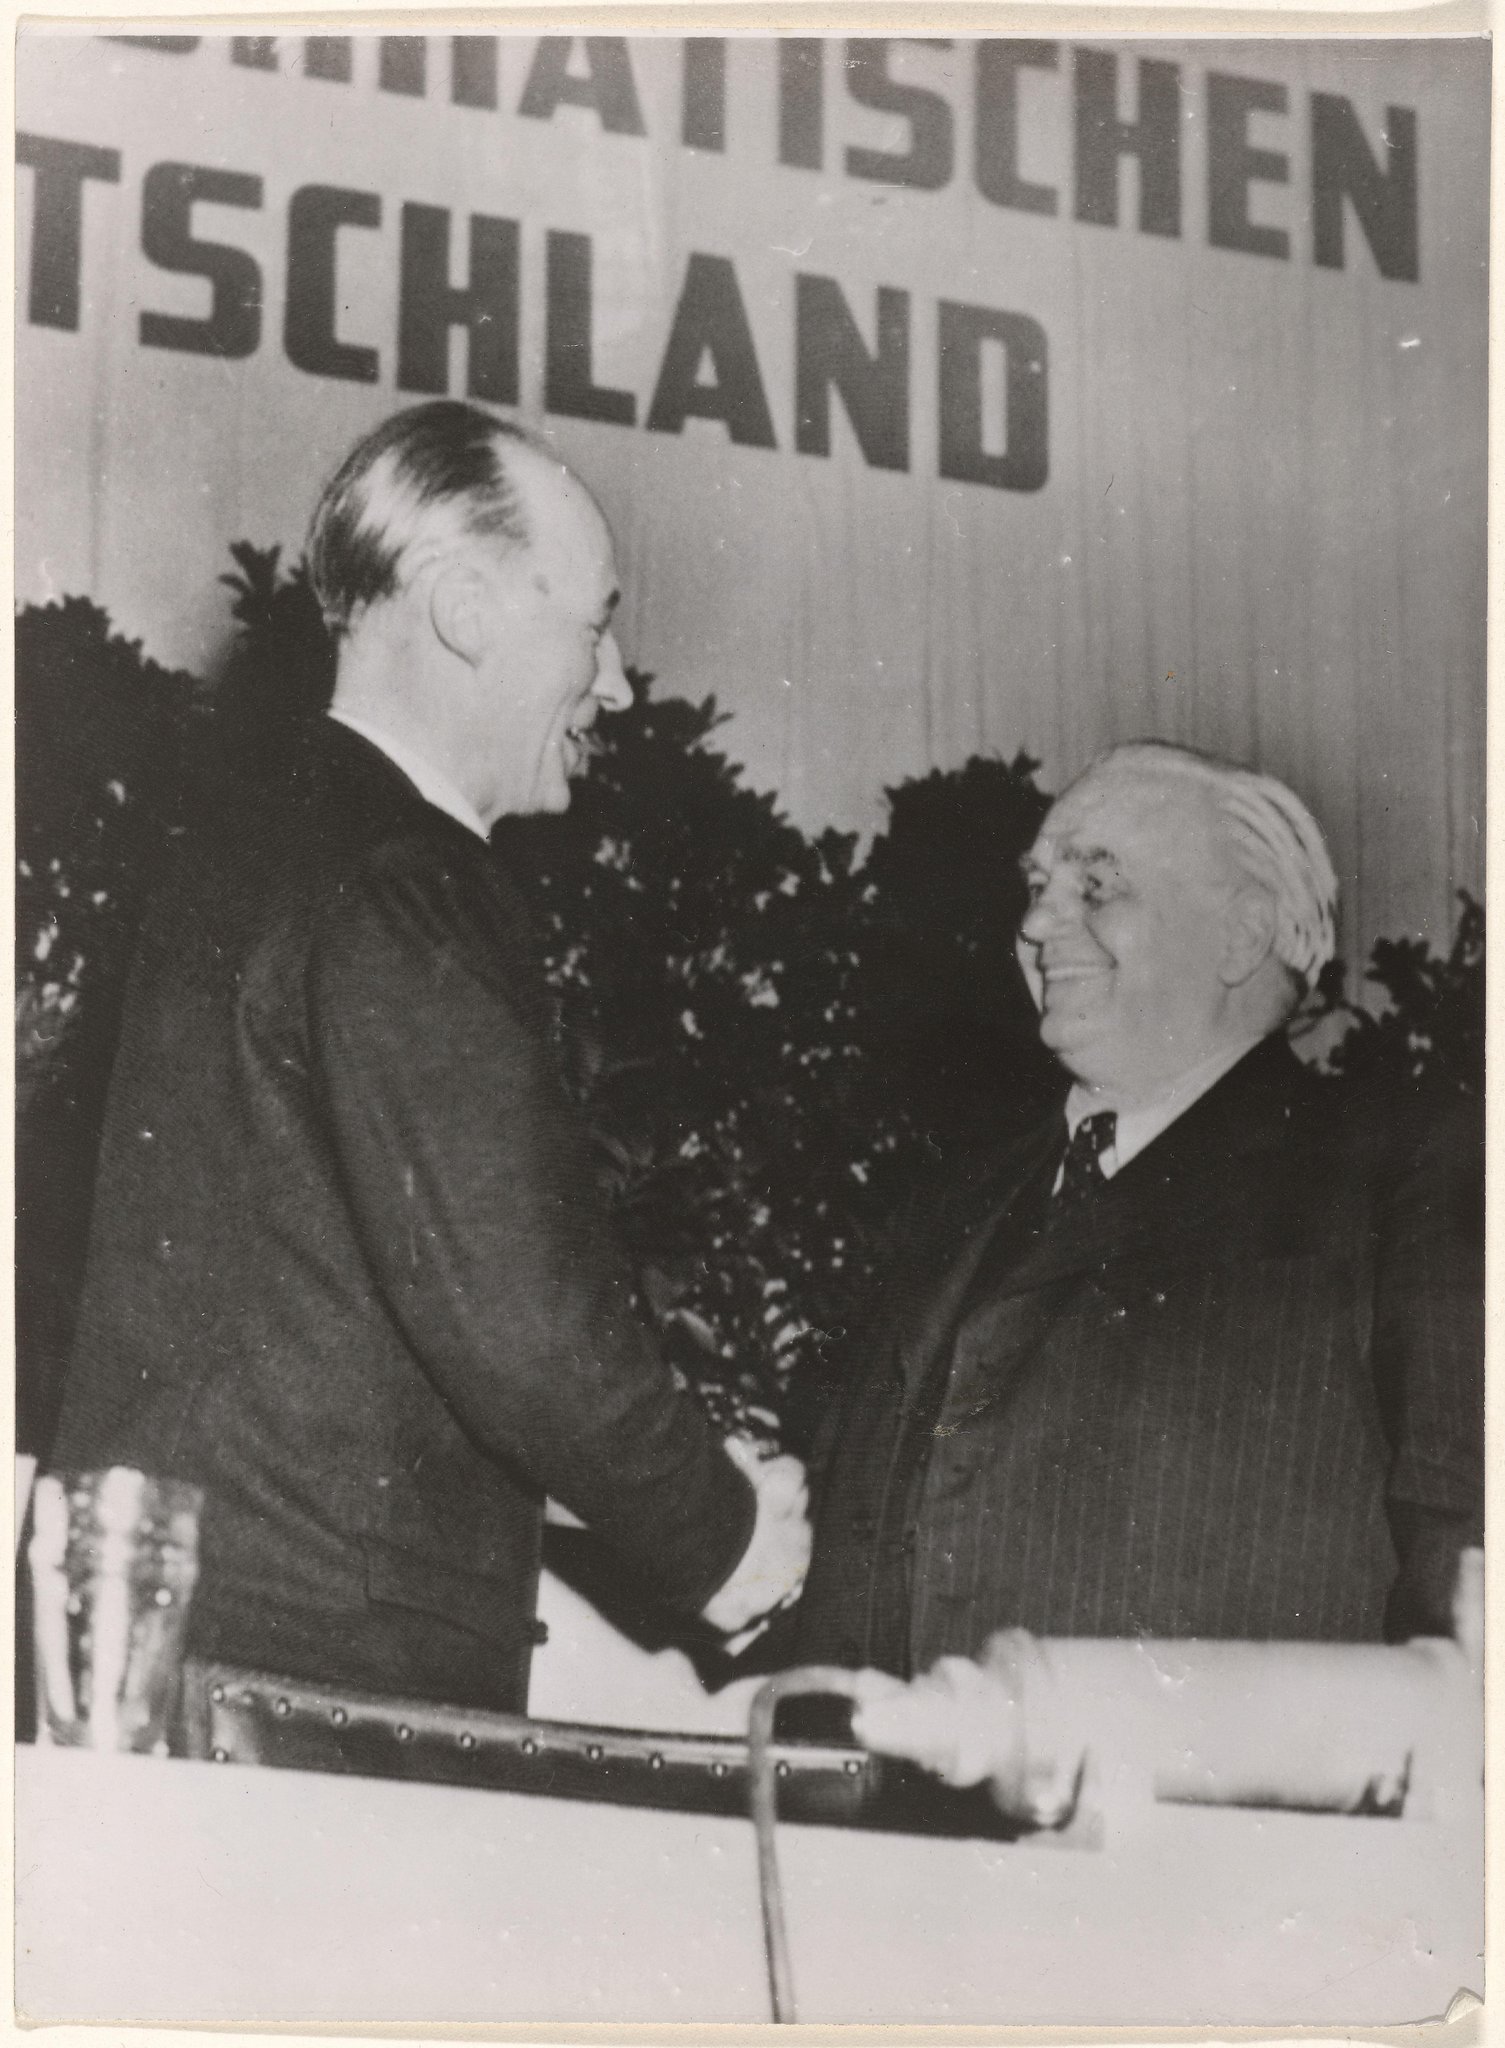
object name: photograph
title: East German govenmentset up in Berlin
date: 1949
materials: photographic support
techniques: gelatin silver print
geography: london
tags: berlin, politician